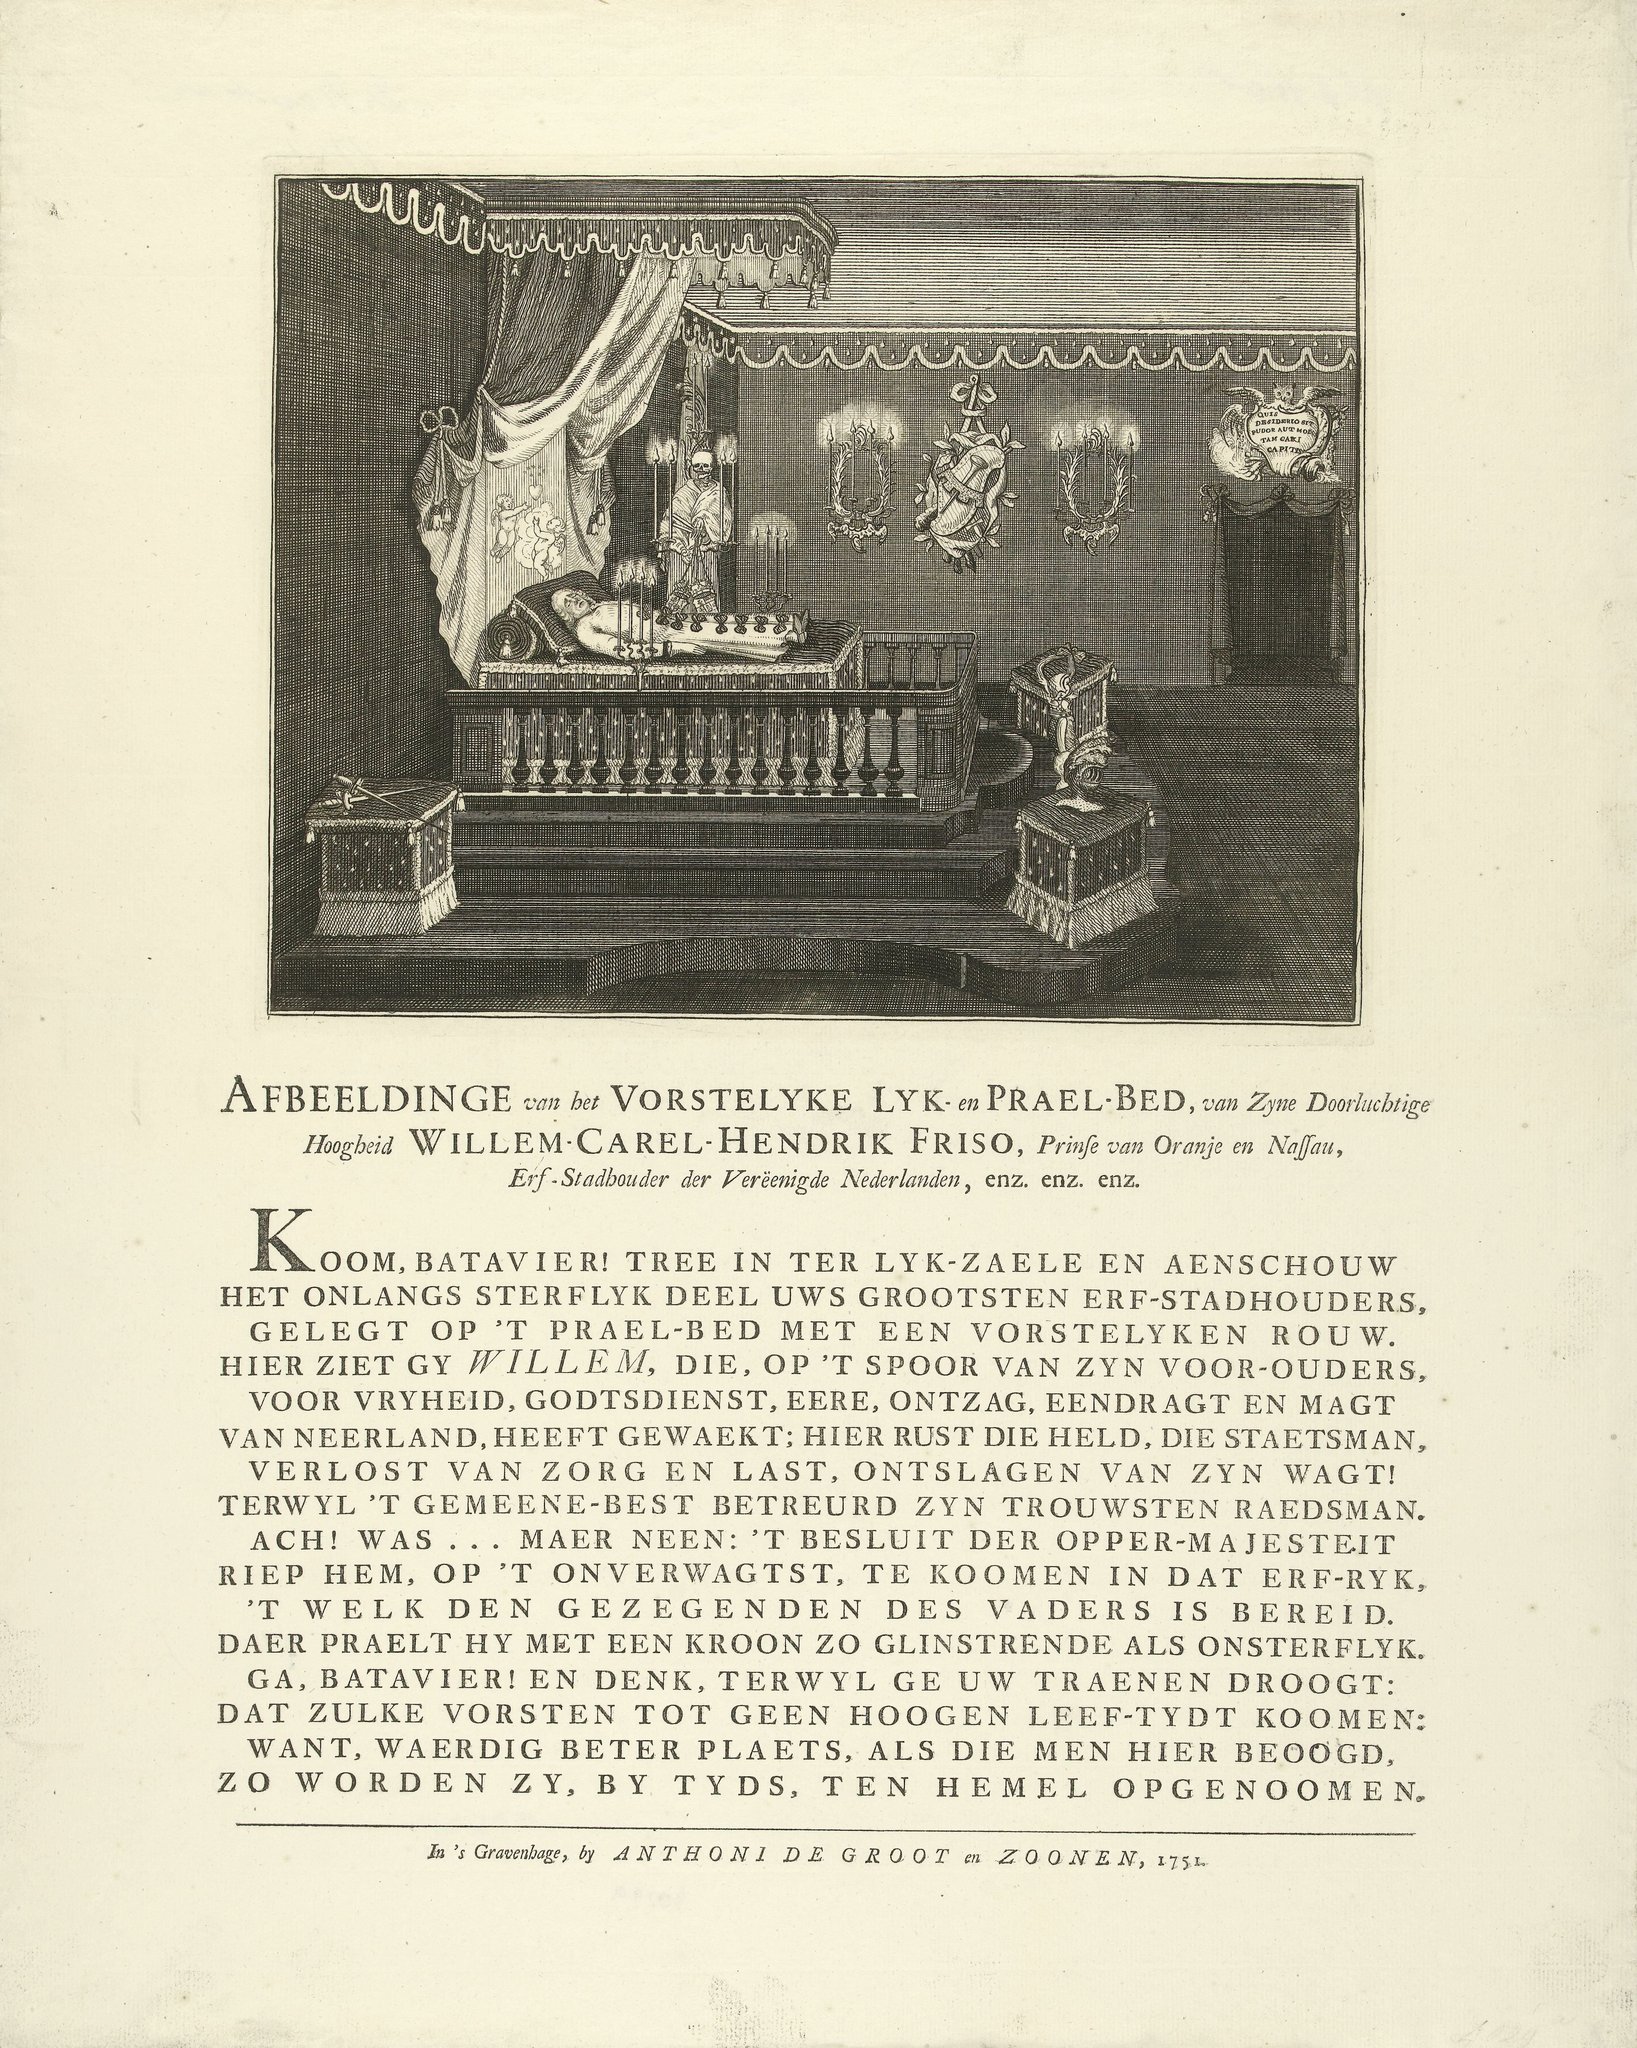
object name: print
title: Praalbed van prins Willem IV, 1751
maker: Anonymous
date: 1751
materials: paper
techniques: engraving, etching, letterpress printing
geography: the hague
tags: the hague, willem iv (prins van oranje-nassau), lying in state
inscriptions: collector's mark: Lugt 2228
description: Rouwkamer met het praalbed van de op 22 oktober overleden prins Willem IV en waarop hij gedurende de maanden november en december van het jaar 1751 opgebaard heeft gelegen. Op het blad onder de plaat staat een vers.